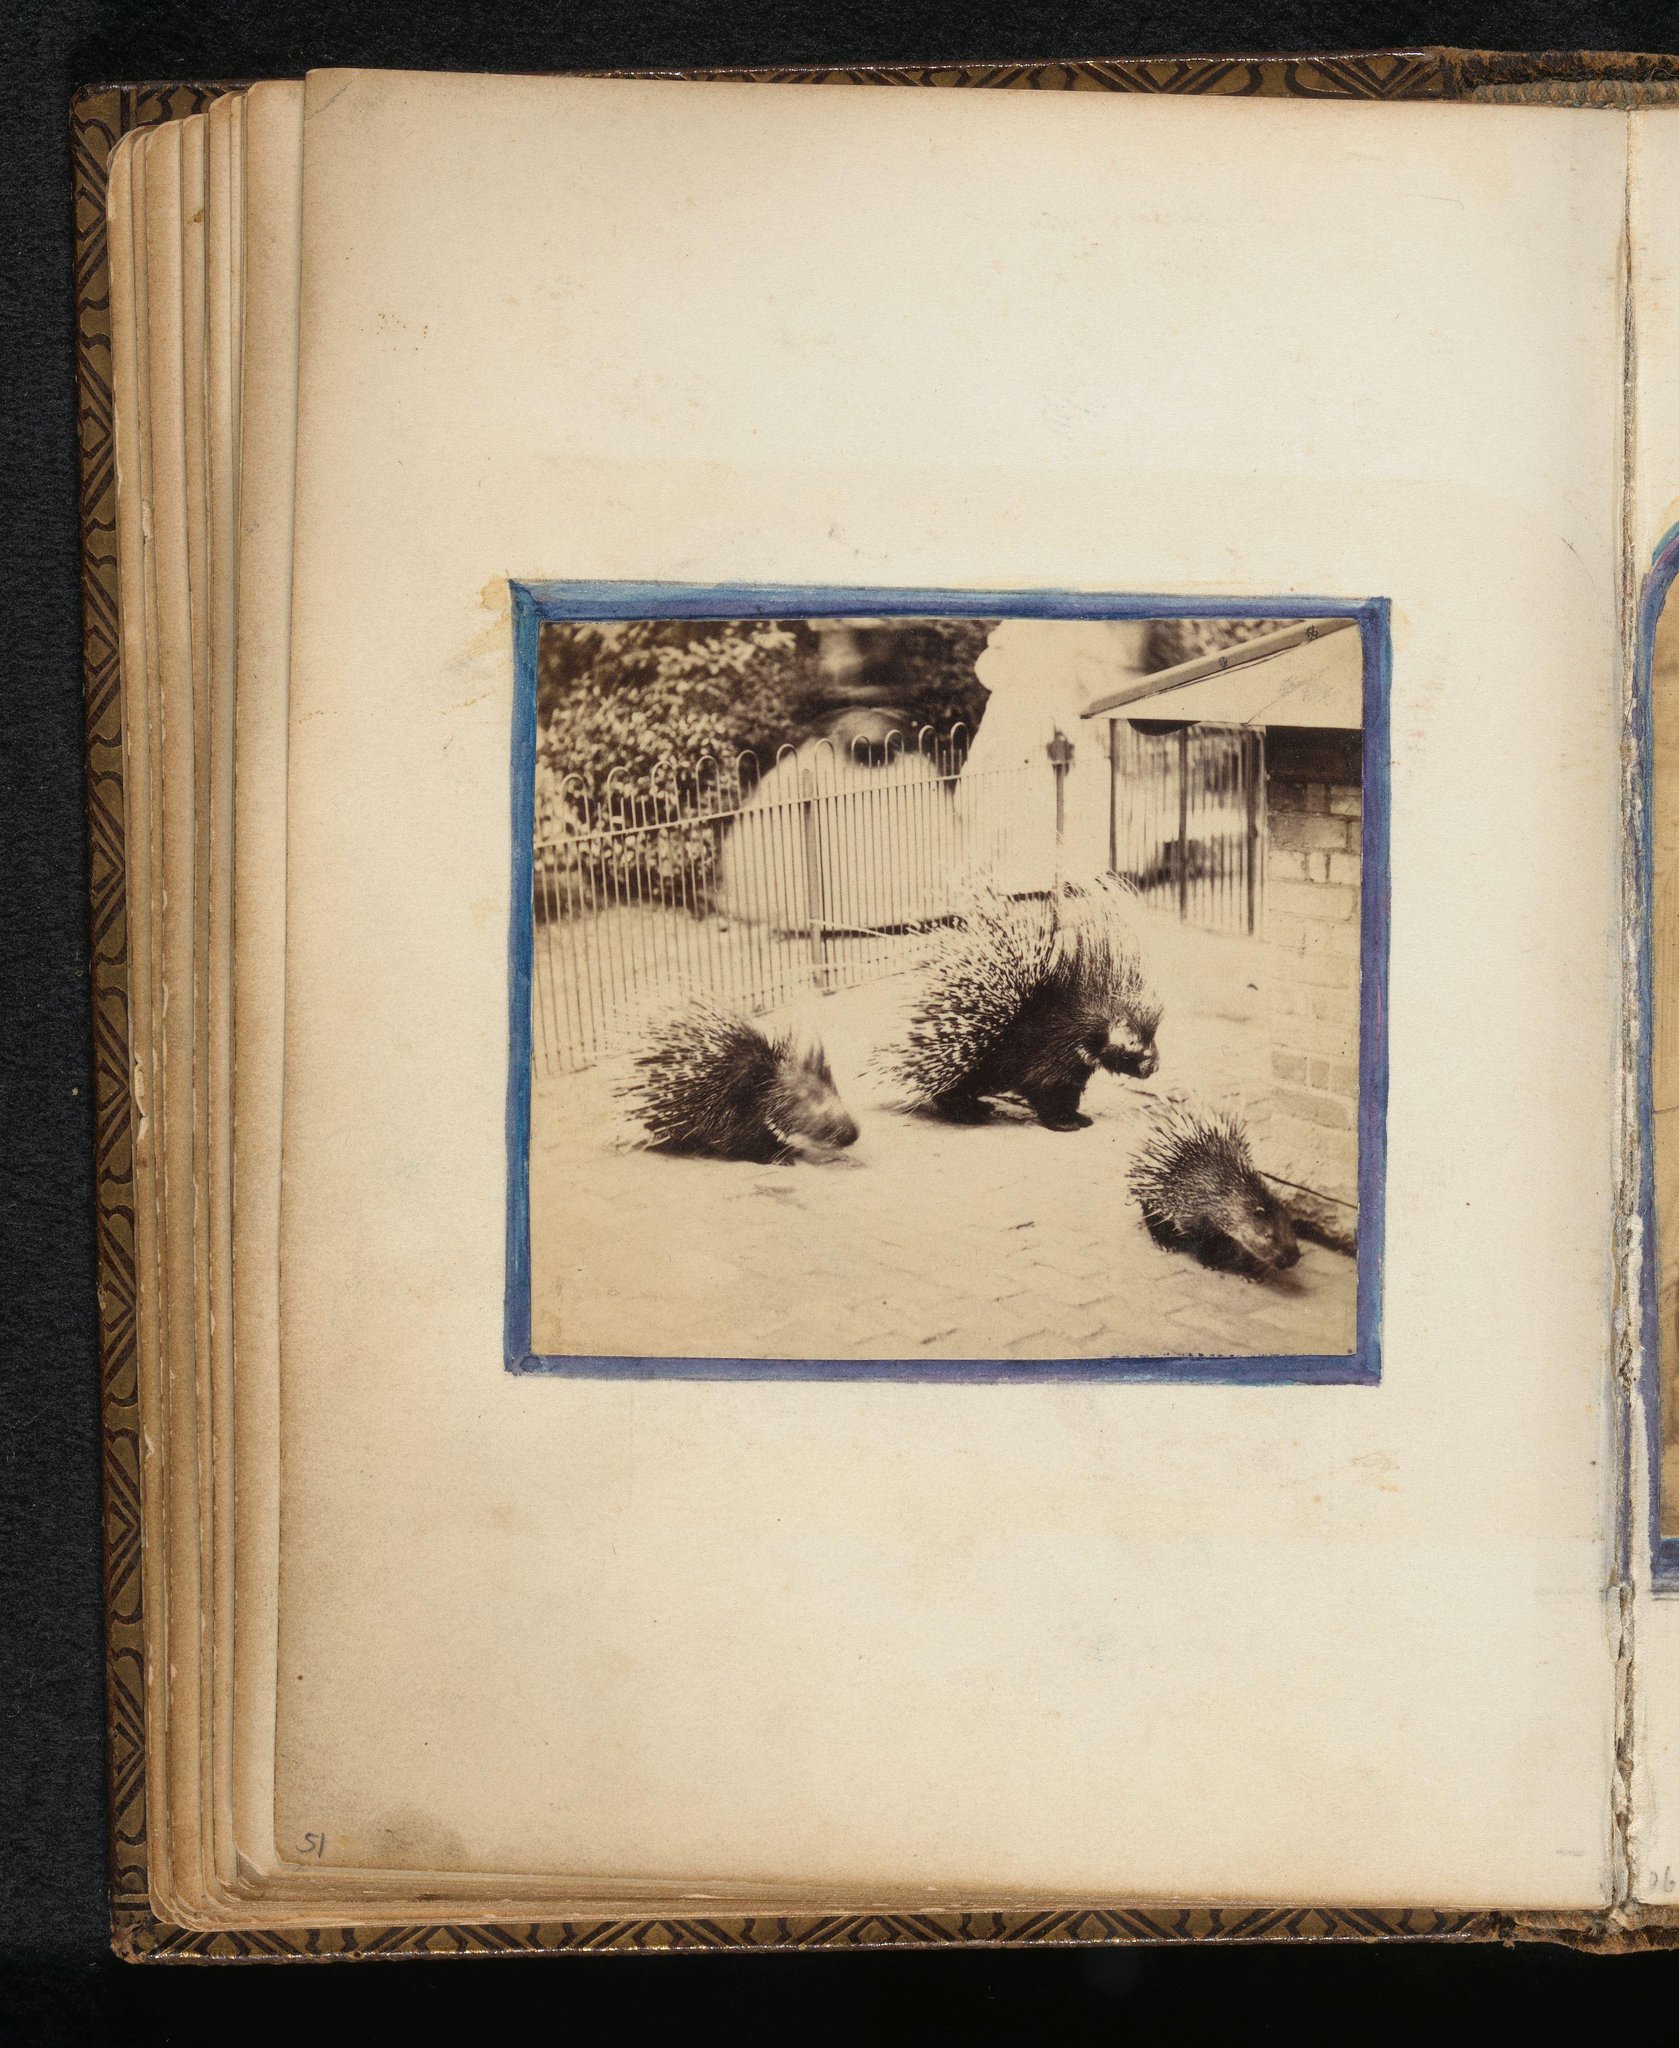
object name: album leaf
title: Stekelvarkens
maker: Anonymous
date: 1865-1867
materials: cardboard, photographic support, watercolor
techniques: albumen print, aquarelle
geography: england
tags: other mammals: porcupine, zoo (as place of recreation)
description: Drie stekelvarkens achter een hek. Foto op albumblad in album met 68 foto's merendeels met geaquarelleerde randversieringen. Het zijn voornamelijk portretten op carte-de-visite formaat.